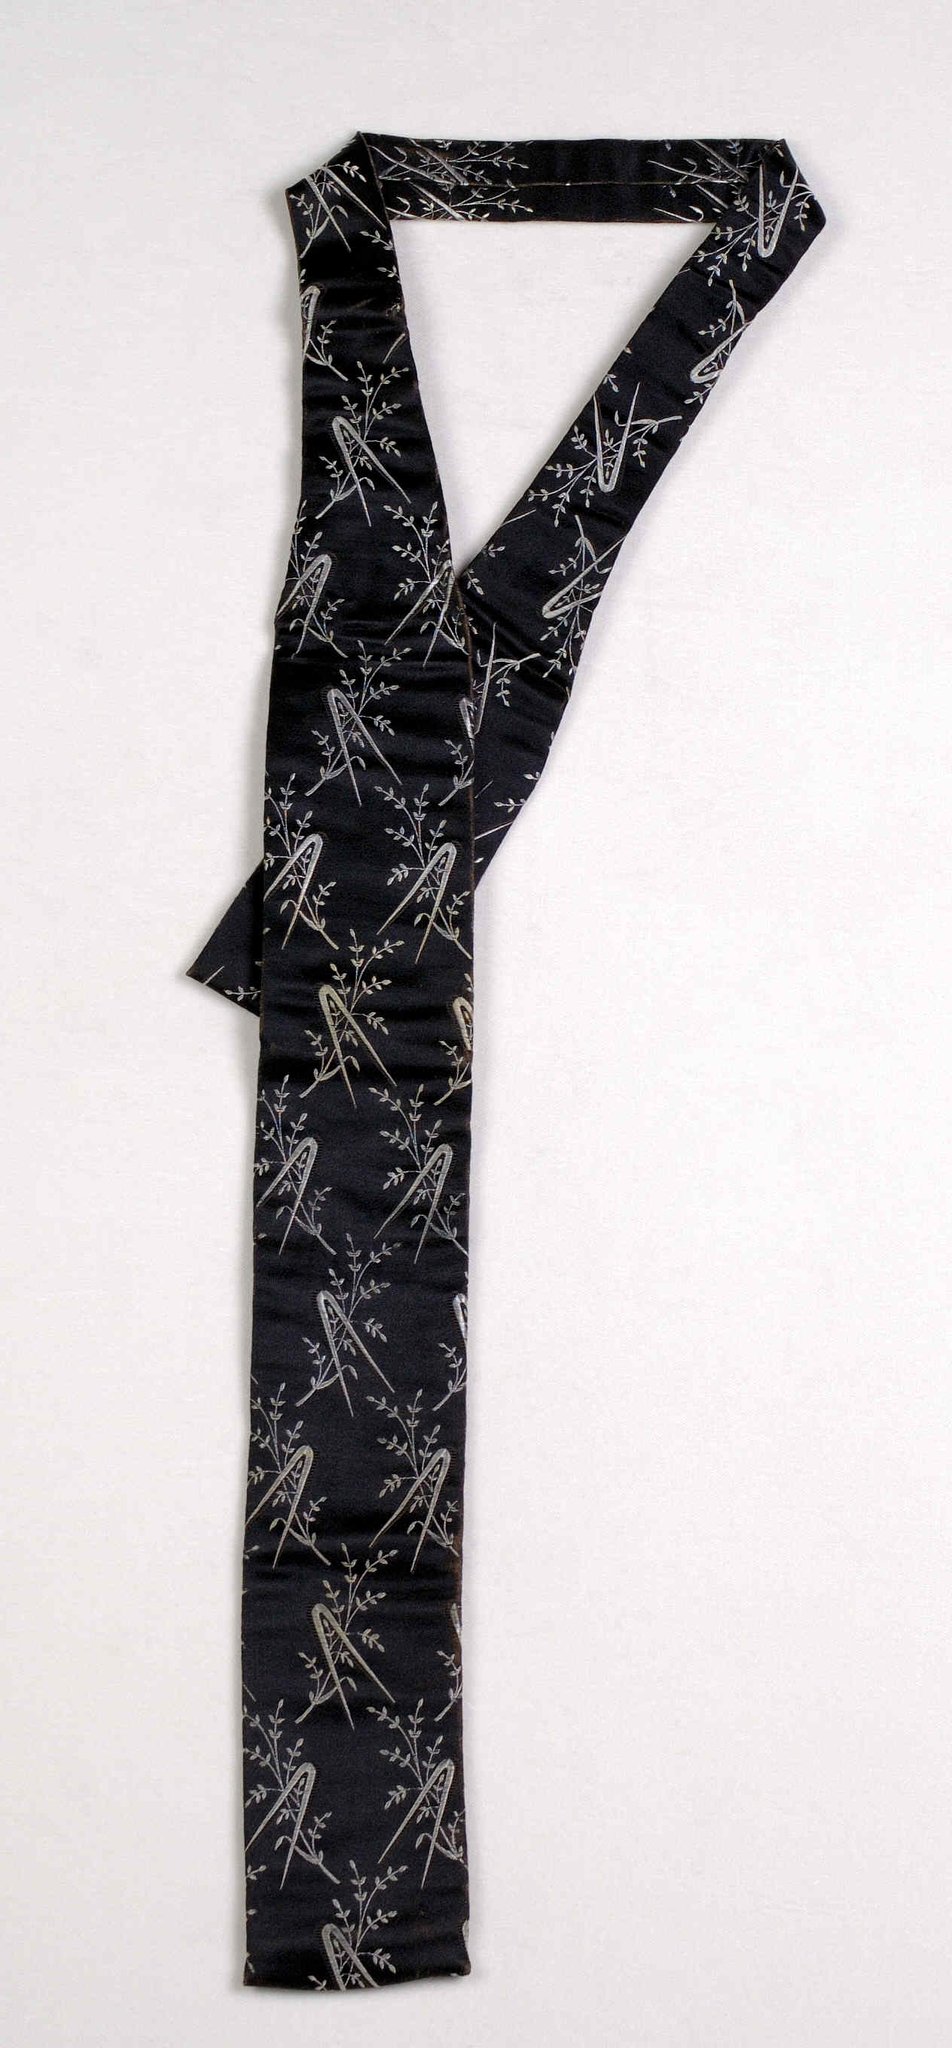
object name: cravat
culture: american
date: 1900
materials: silk